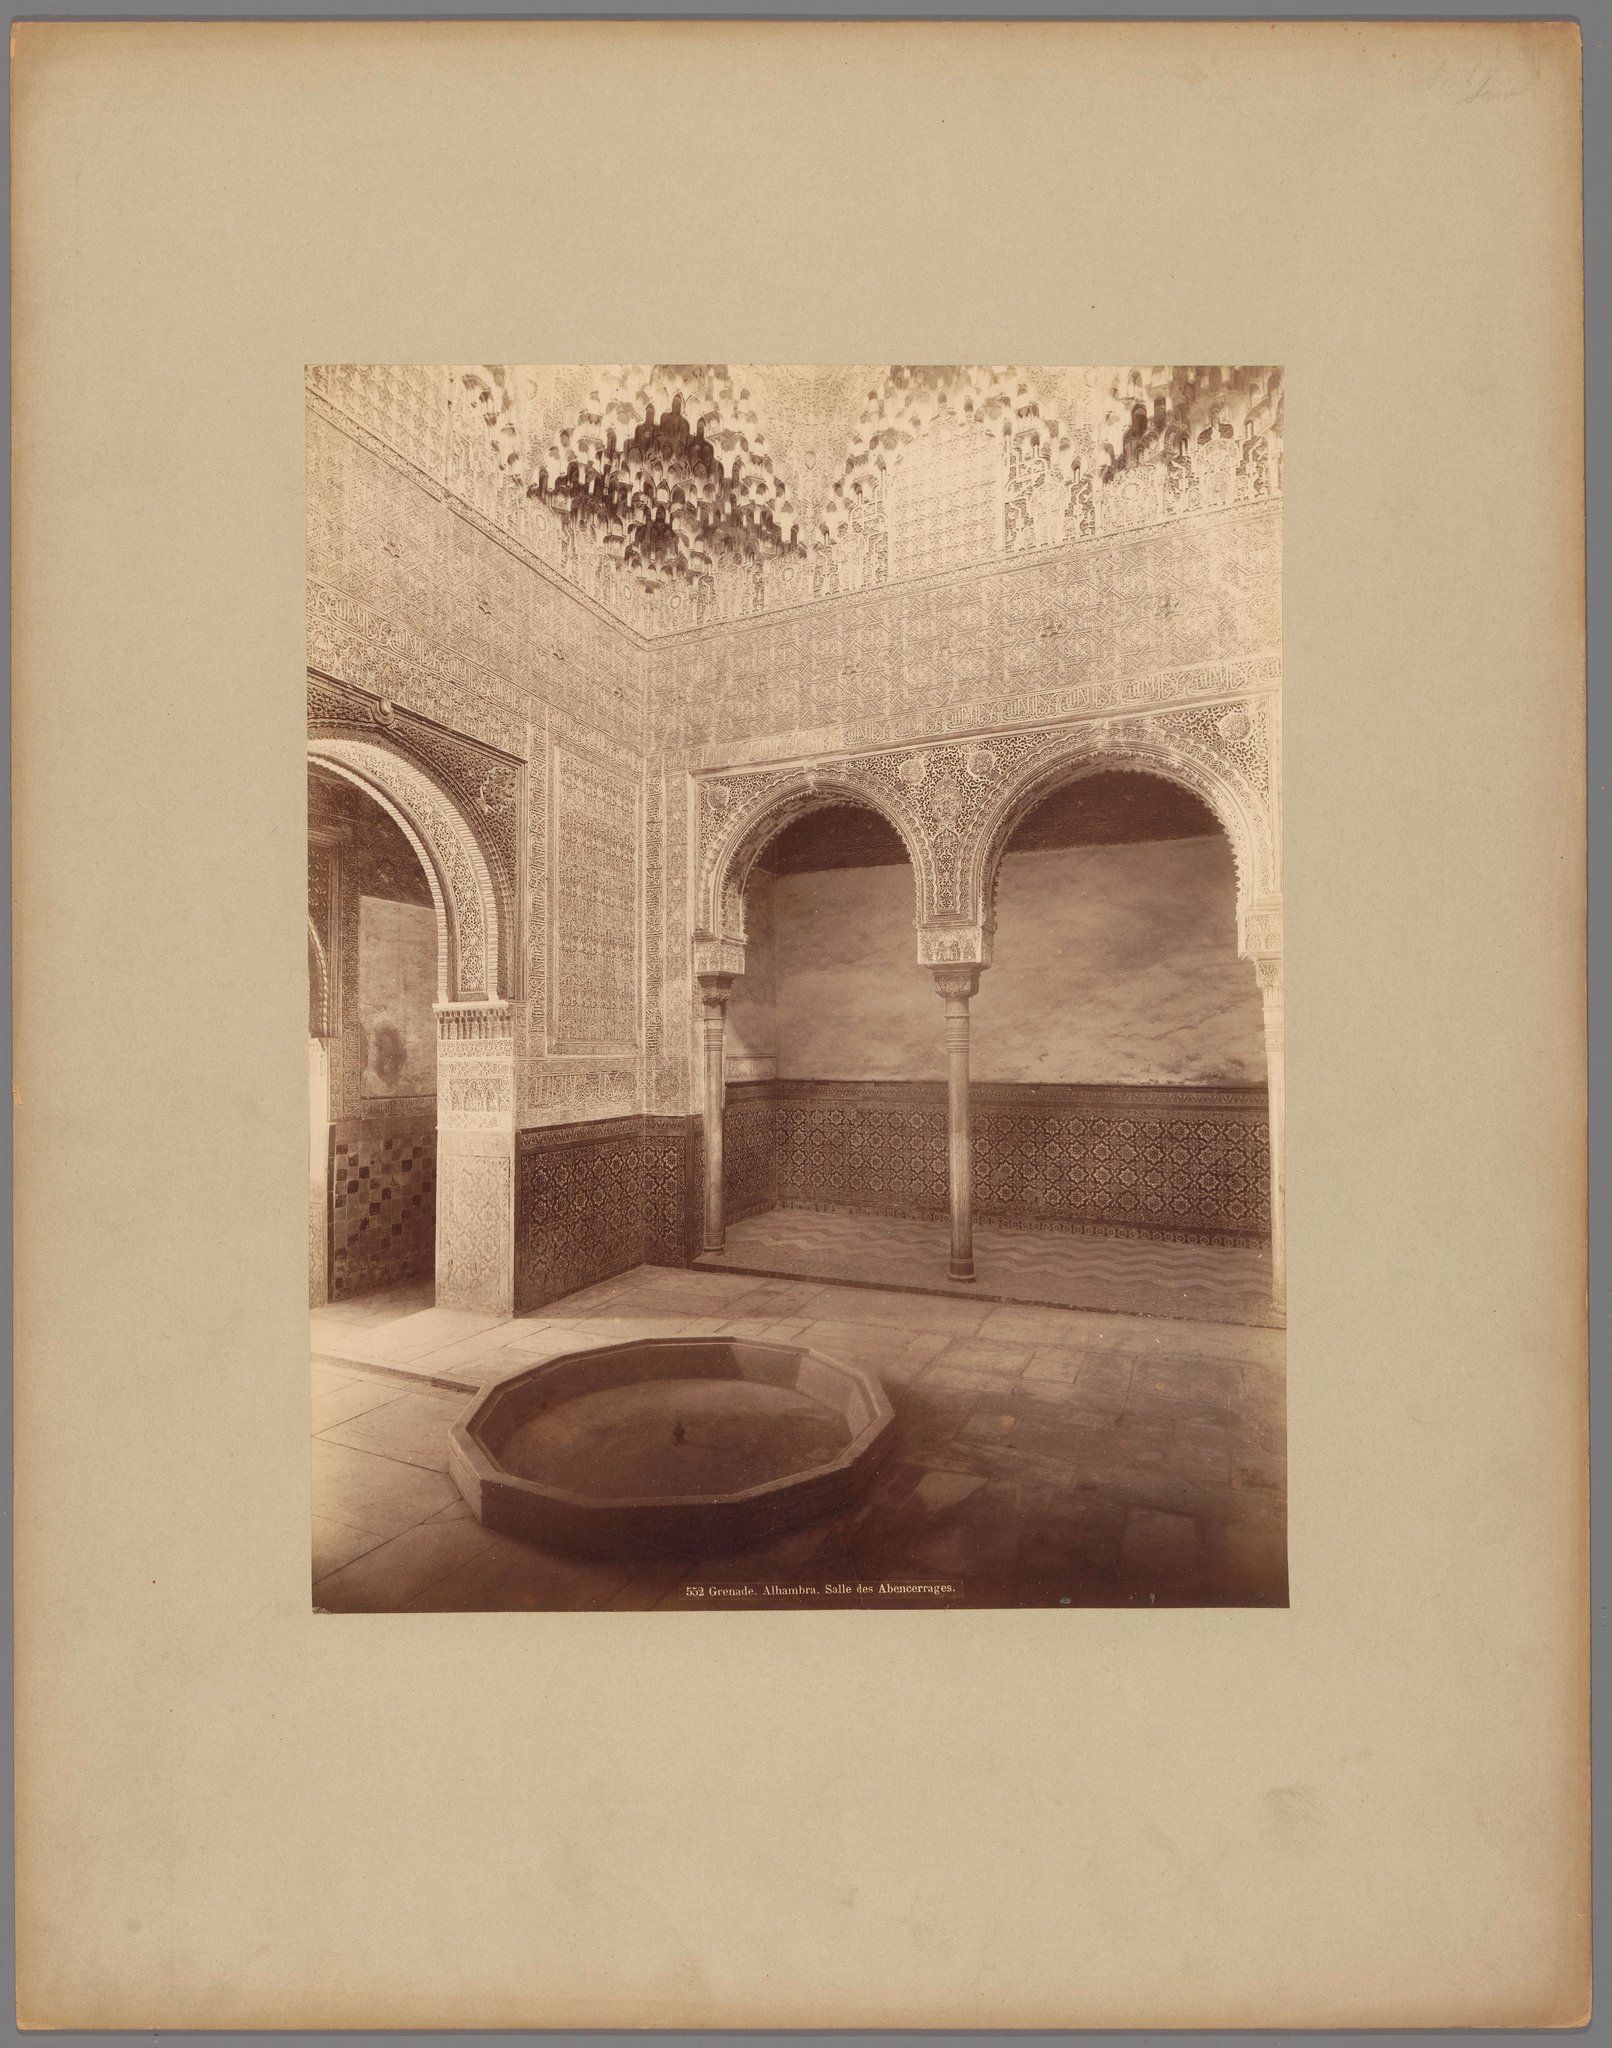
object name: photograph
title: Grenade. Alhambra. Salle des Abencerrages.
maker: Anonymous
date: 1875-1900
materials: cardboard, photographic support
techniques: albumen print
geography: granada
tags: fortress, interior ~ representation of a building, fountain (indoors)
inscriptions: collector's mark: Lugt 3937, number: ‘552’, inscription: ‘B.F.K.’, inscription: ‘Syrie’